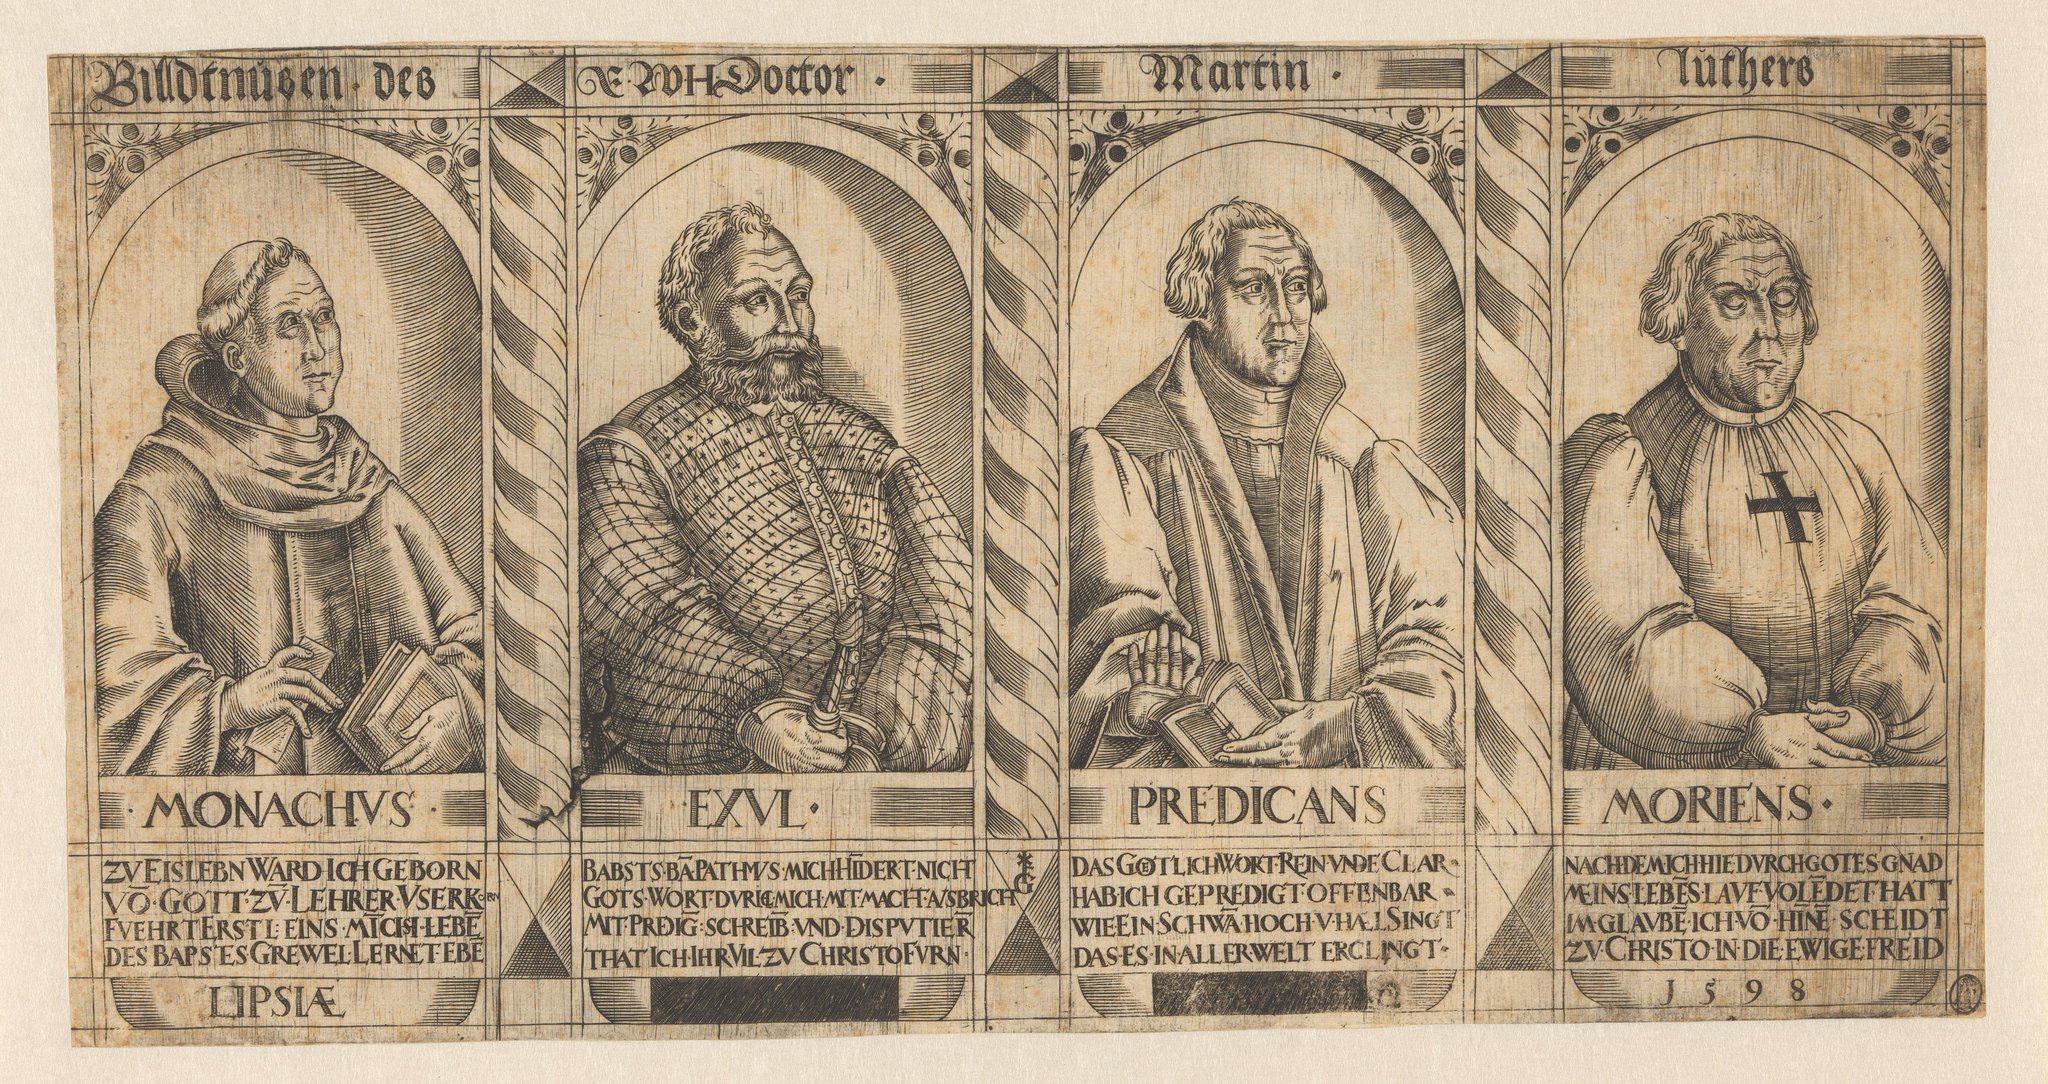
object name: print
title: Vier stadia uit het leven van Martin Luther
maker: monogrammist jfg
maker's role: print maker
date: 1598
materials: ink, paper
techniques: engraving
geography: leipzig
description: De vier stadia uit het leven van Martin Luther. Drie portretten van hem als monnik, als predikant en op zijn sterfbed, en zijn verbanning uitgebeeld door een portret van Frederik II van Saksen, zijn beschermheer.